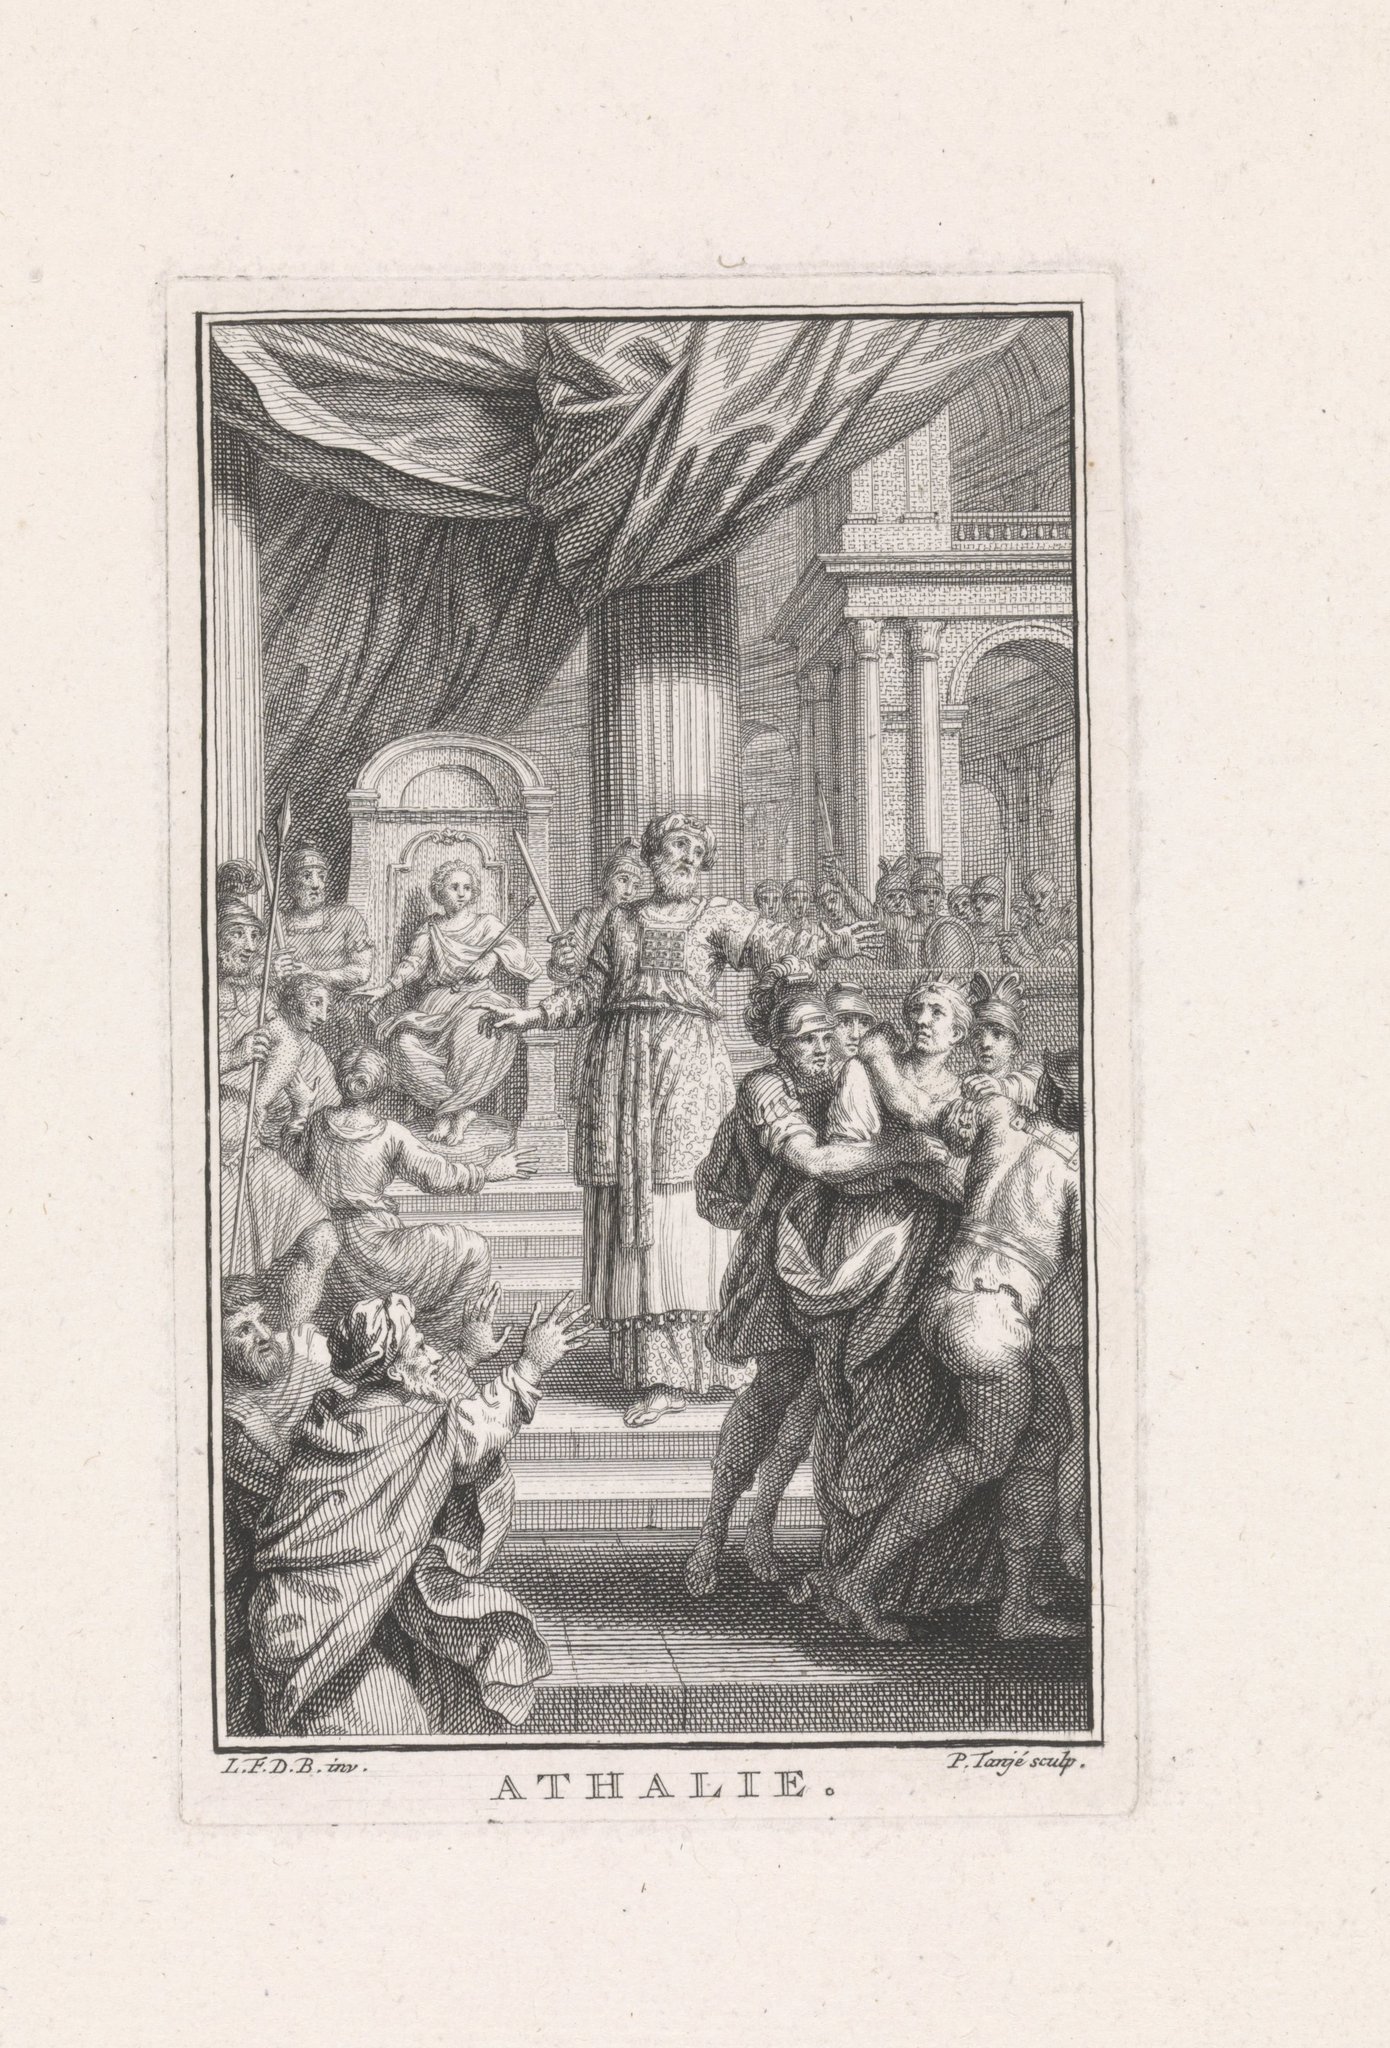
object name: print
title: Athalie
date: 1743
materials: paper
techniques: engraving, etching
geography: amsterdam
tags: death of athalia: she is seized by soldiers, brought to the palace and killed at the horse gate, tragedy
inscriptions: collector's mark: Lugt 2228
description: Koningin Atalja wordt weggeleid om gedood te worden. Op de troon zit de jonge koning Joas en in het midden staat de hogepriester Jojada. Boekillustratie bij de tragedie 'Athalie' van Jean Baptiste Racine.